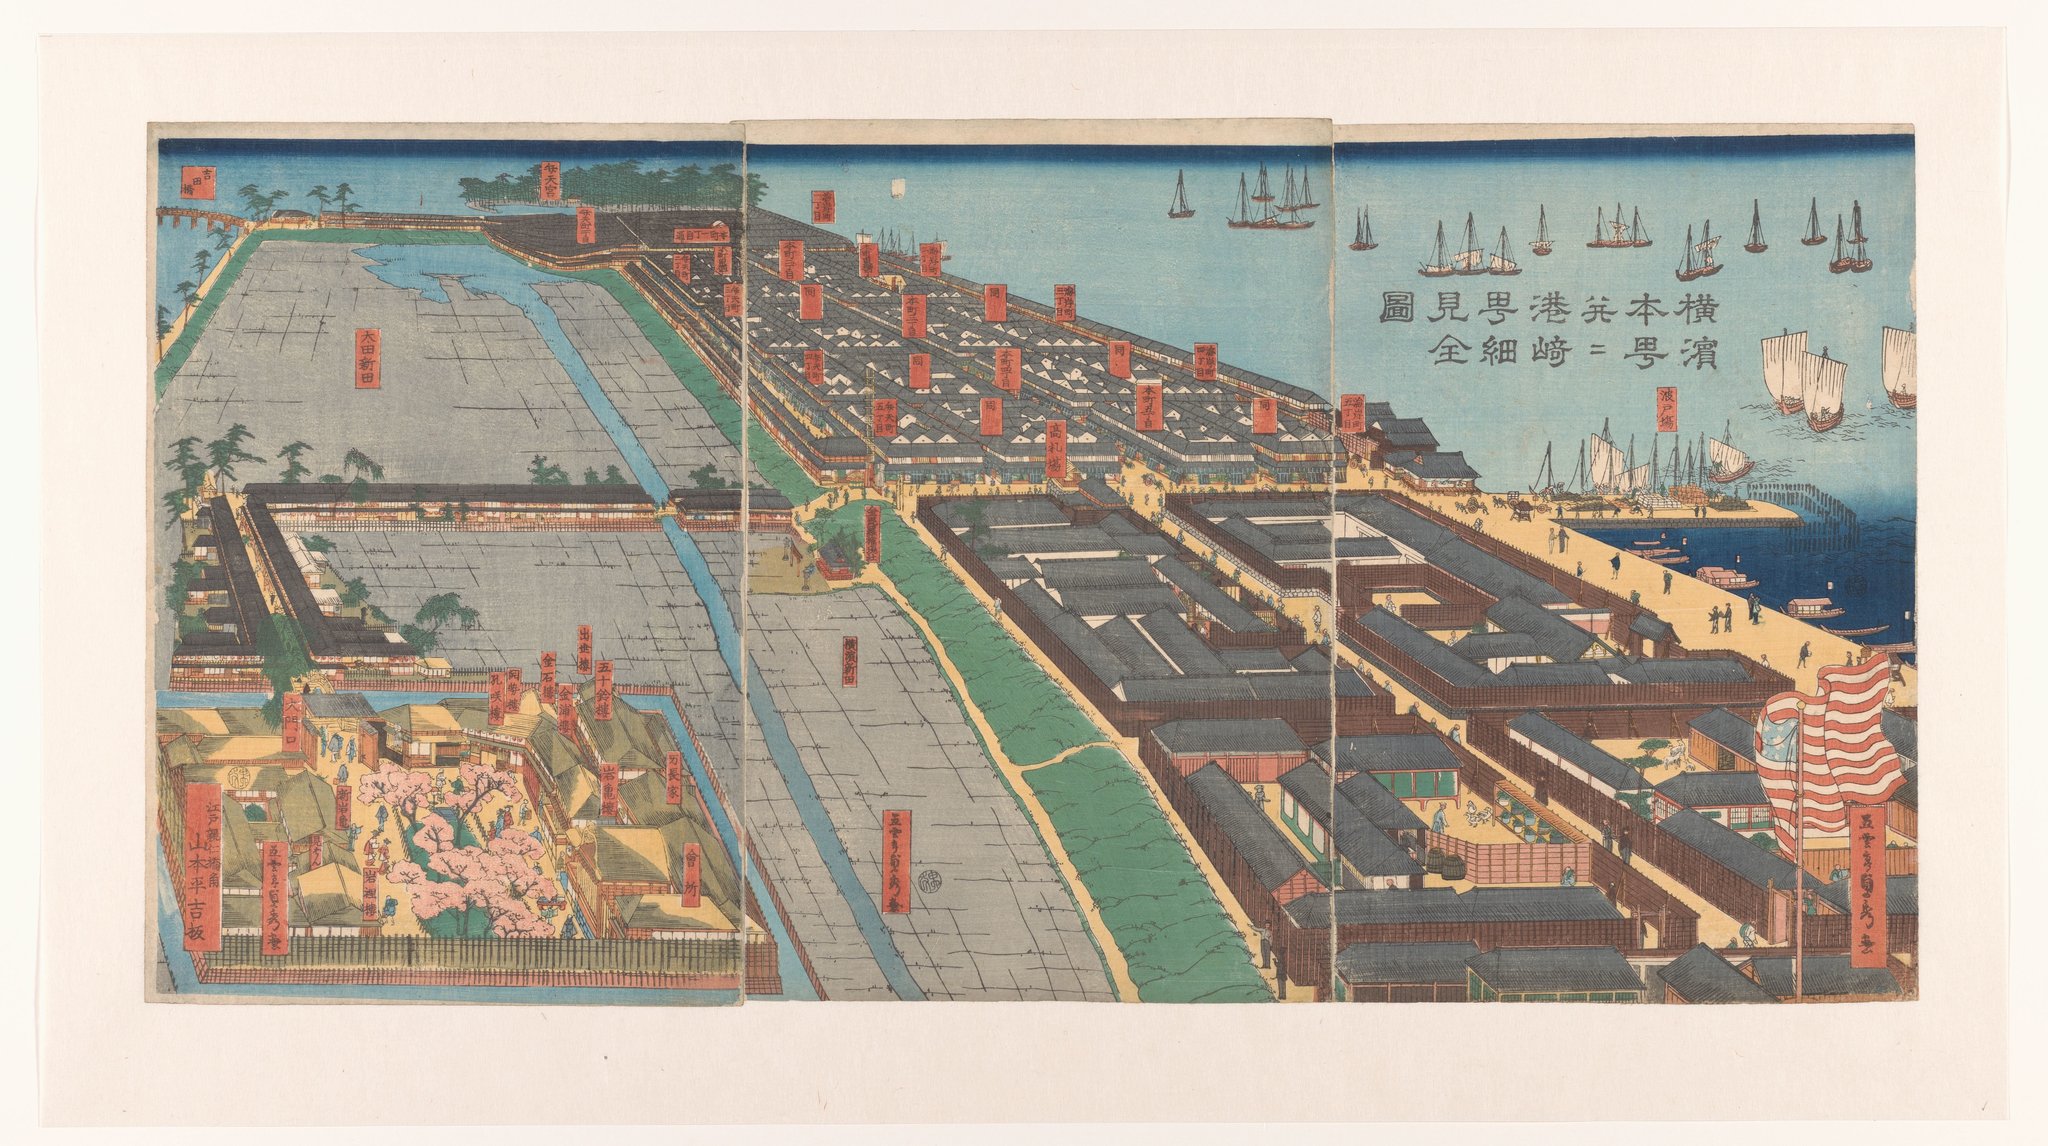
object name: print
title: Overzicht van de wijk Honcho en het Miyozaki kwartier in Yokohama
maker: utagawa sadahide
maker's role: draughtsman, print maker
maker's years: 1807-1873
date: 1804-1860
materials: paper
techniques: woodcut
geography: japan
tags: harbour, city-view in general; 'veduta'